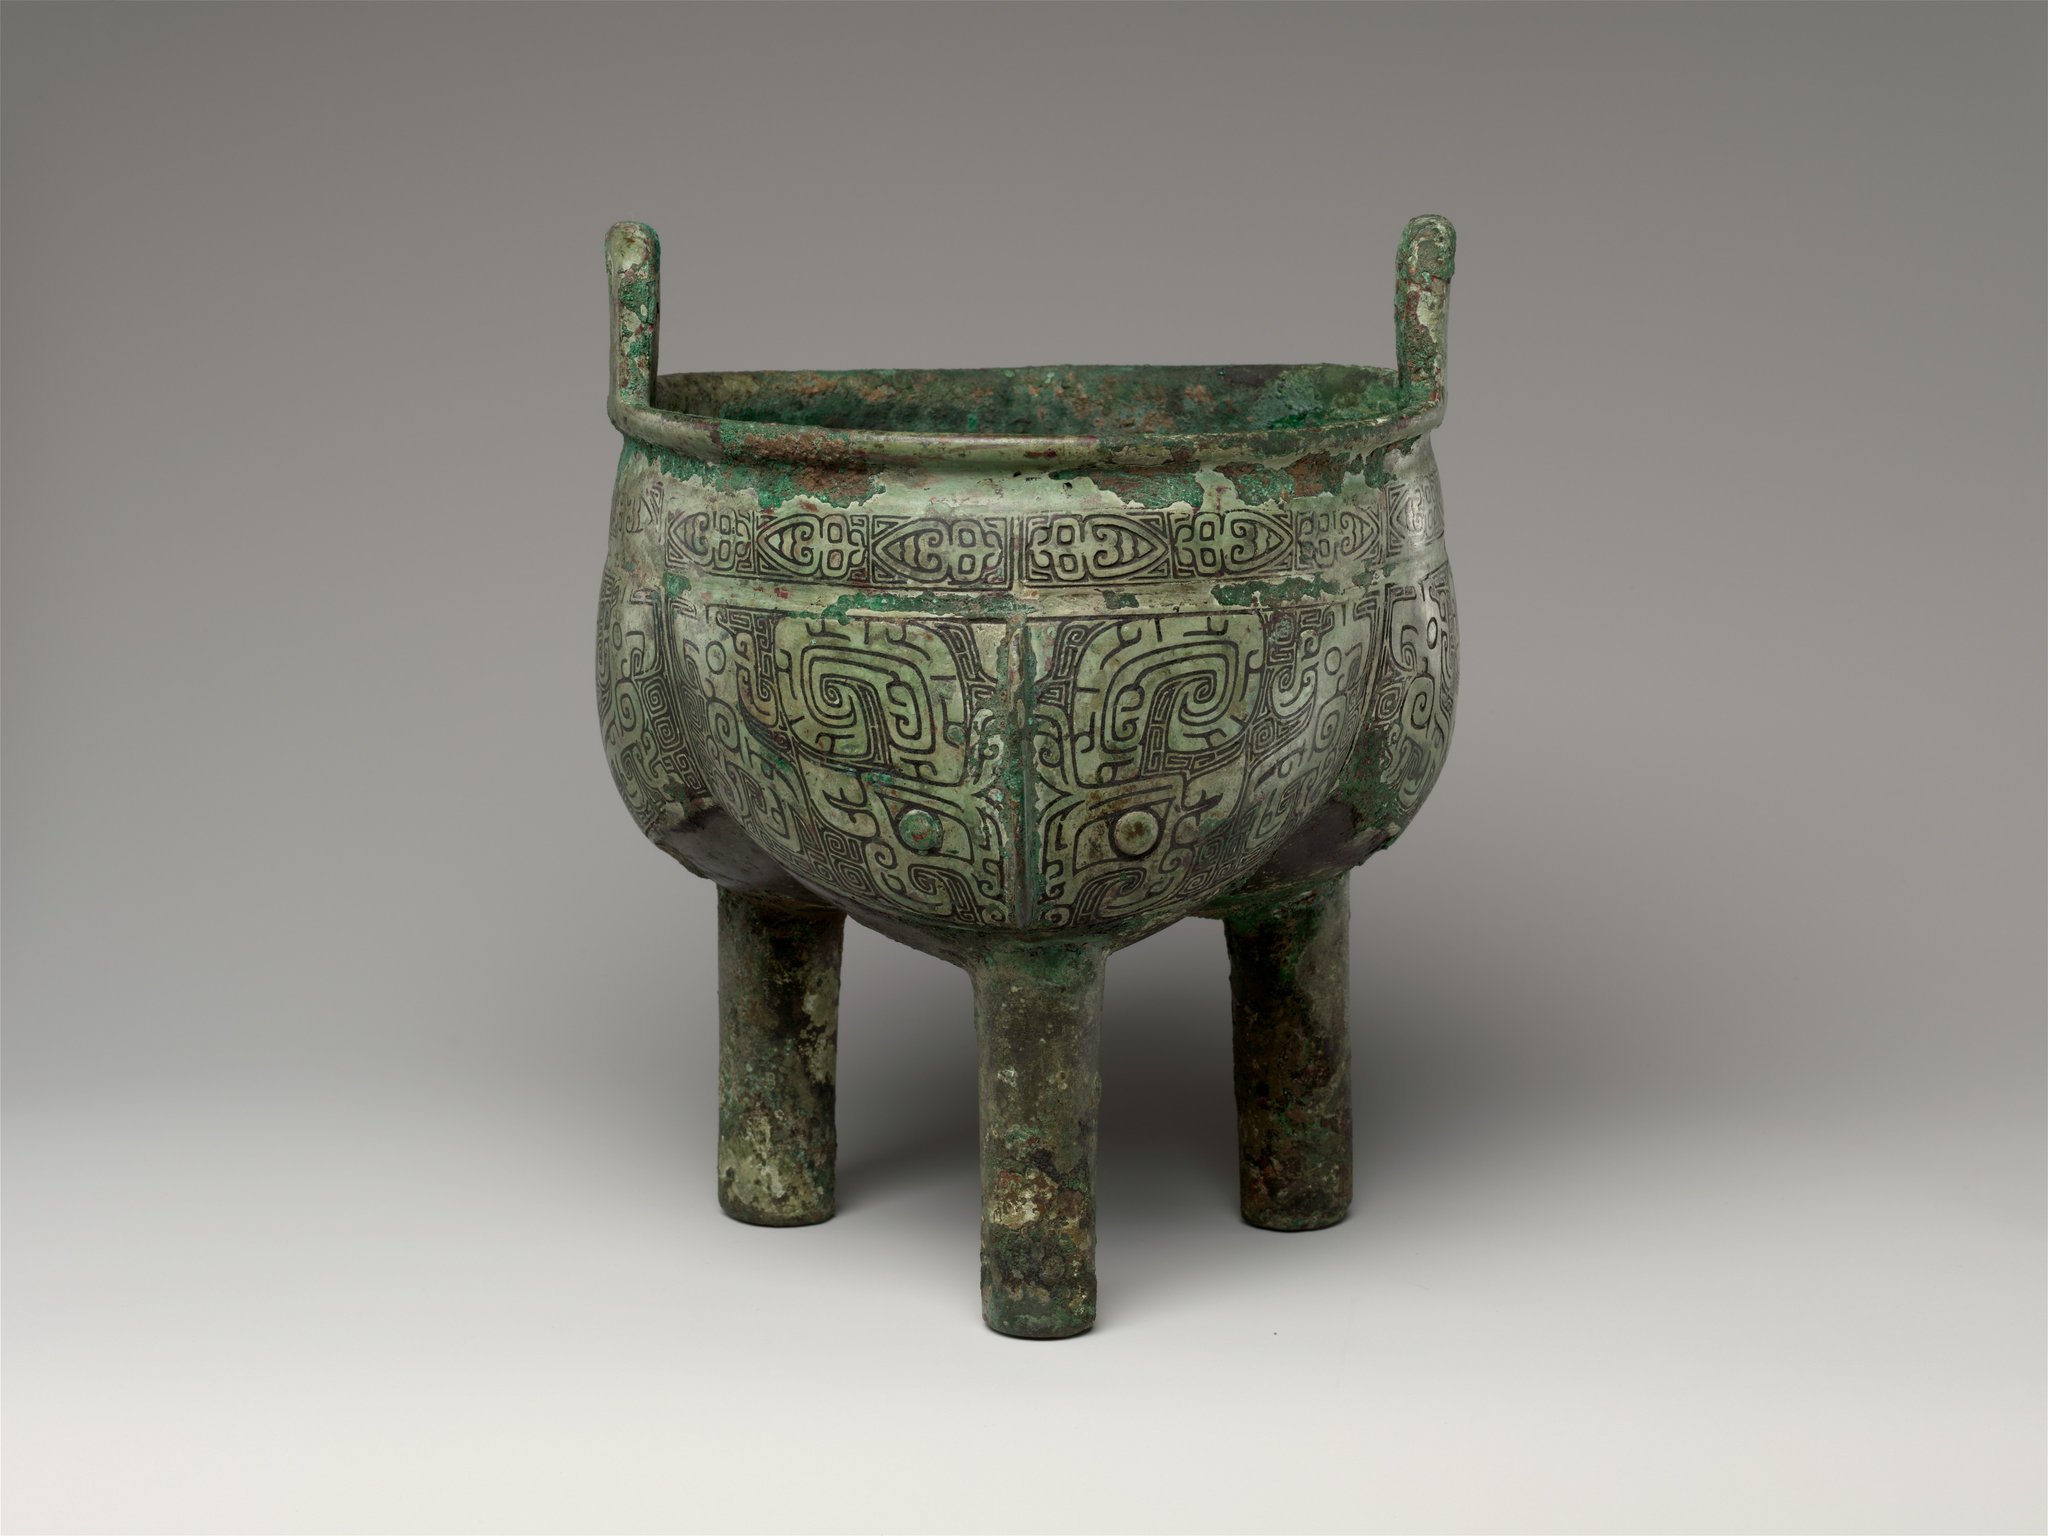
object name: cauldron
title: Lobed tripod cauldron (Liding)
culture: chinese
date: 1200-1001 BCE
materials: bronze, pigment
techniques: inlay